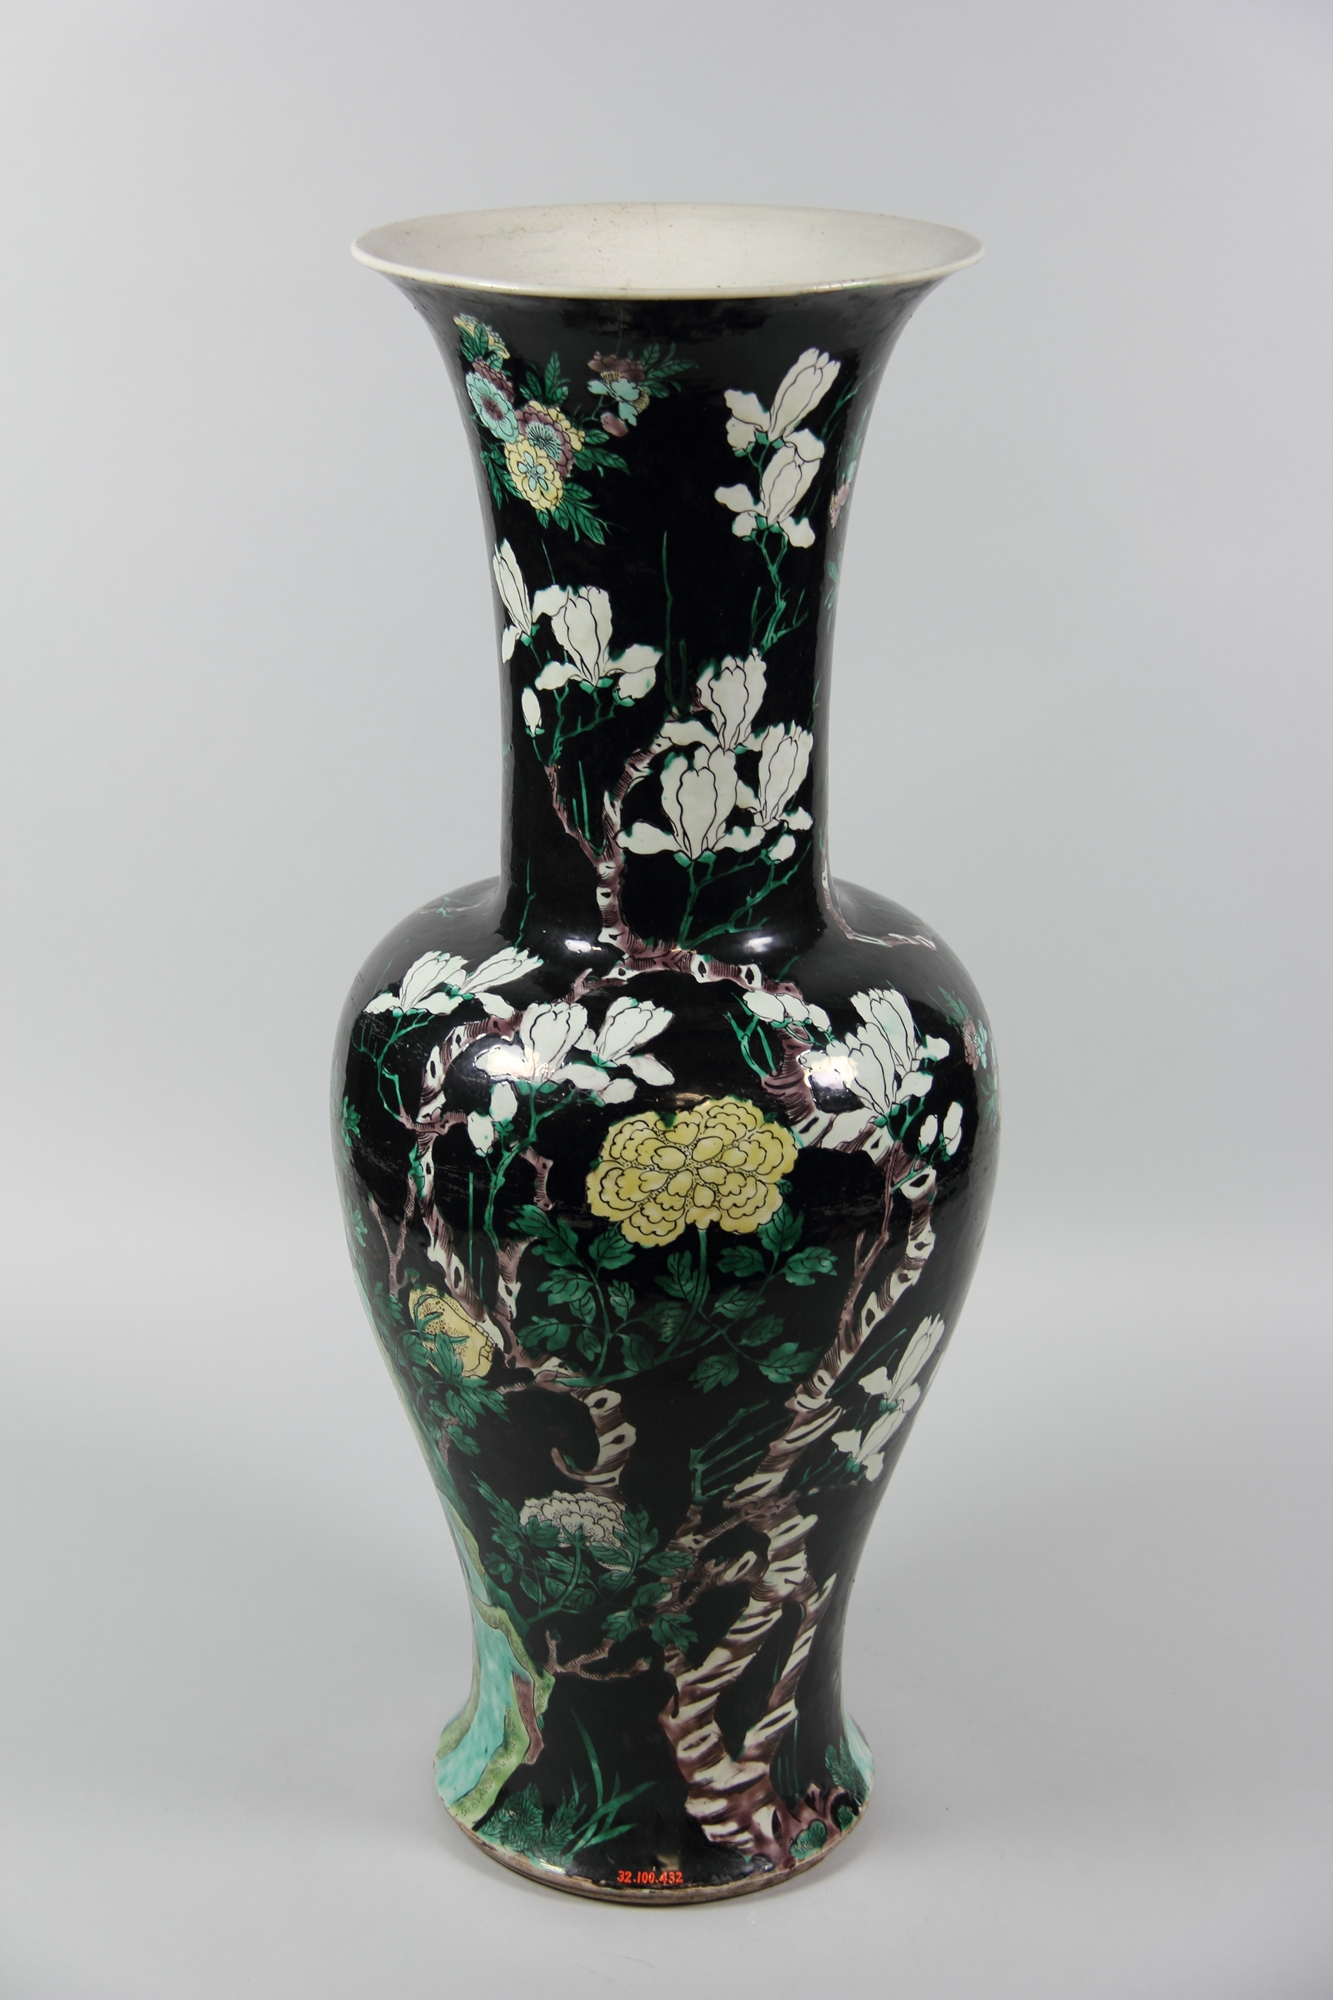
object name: vase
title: Vase with pheasants, rocks, and flowers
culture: chinese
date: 1701-1800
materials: enamel, porcelain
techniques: overglaze, painting, polychrome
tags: flowers